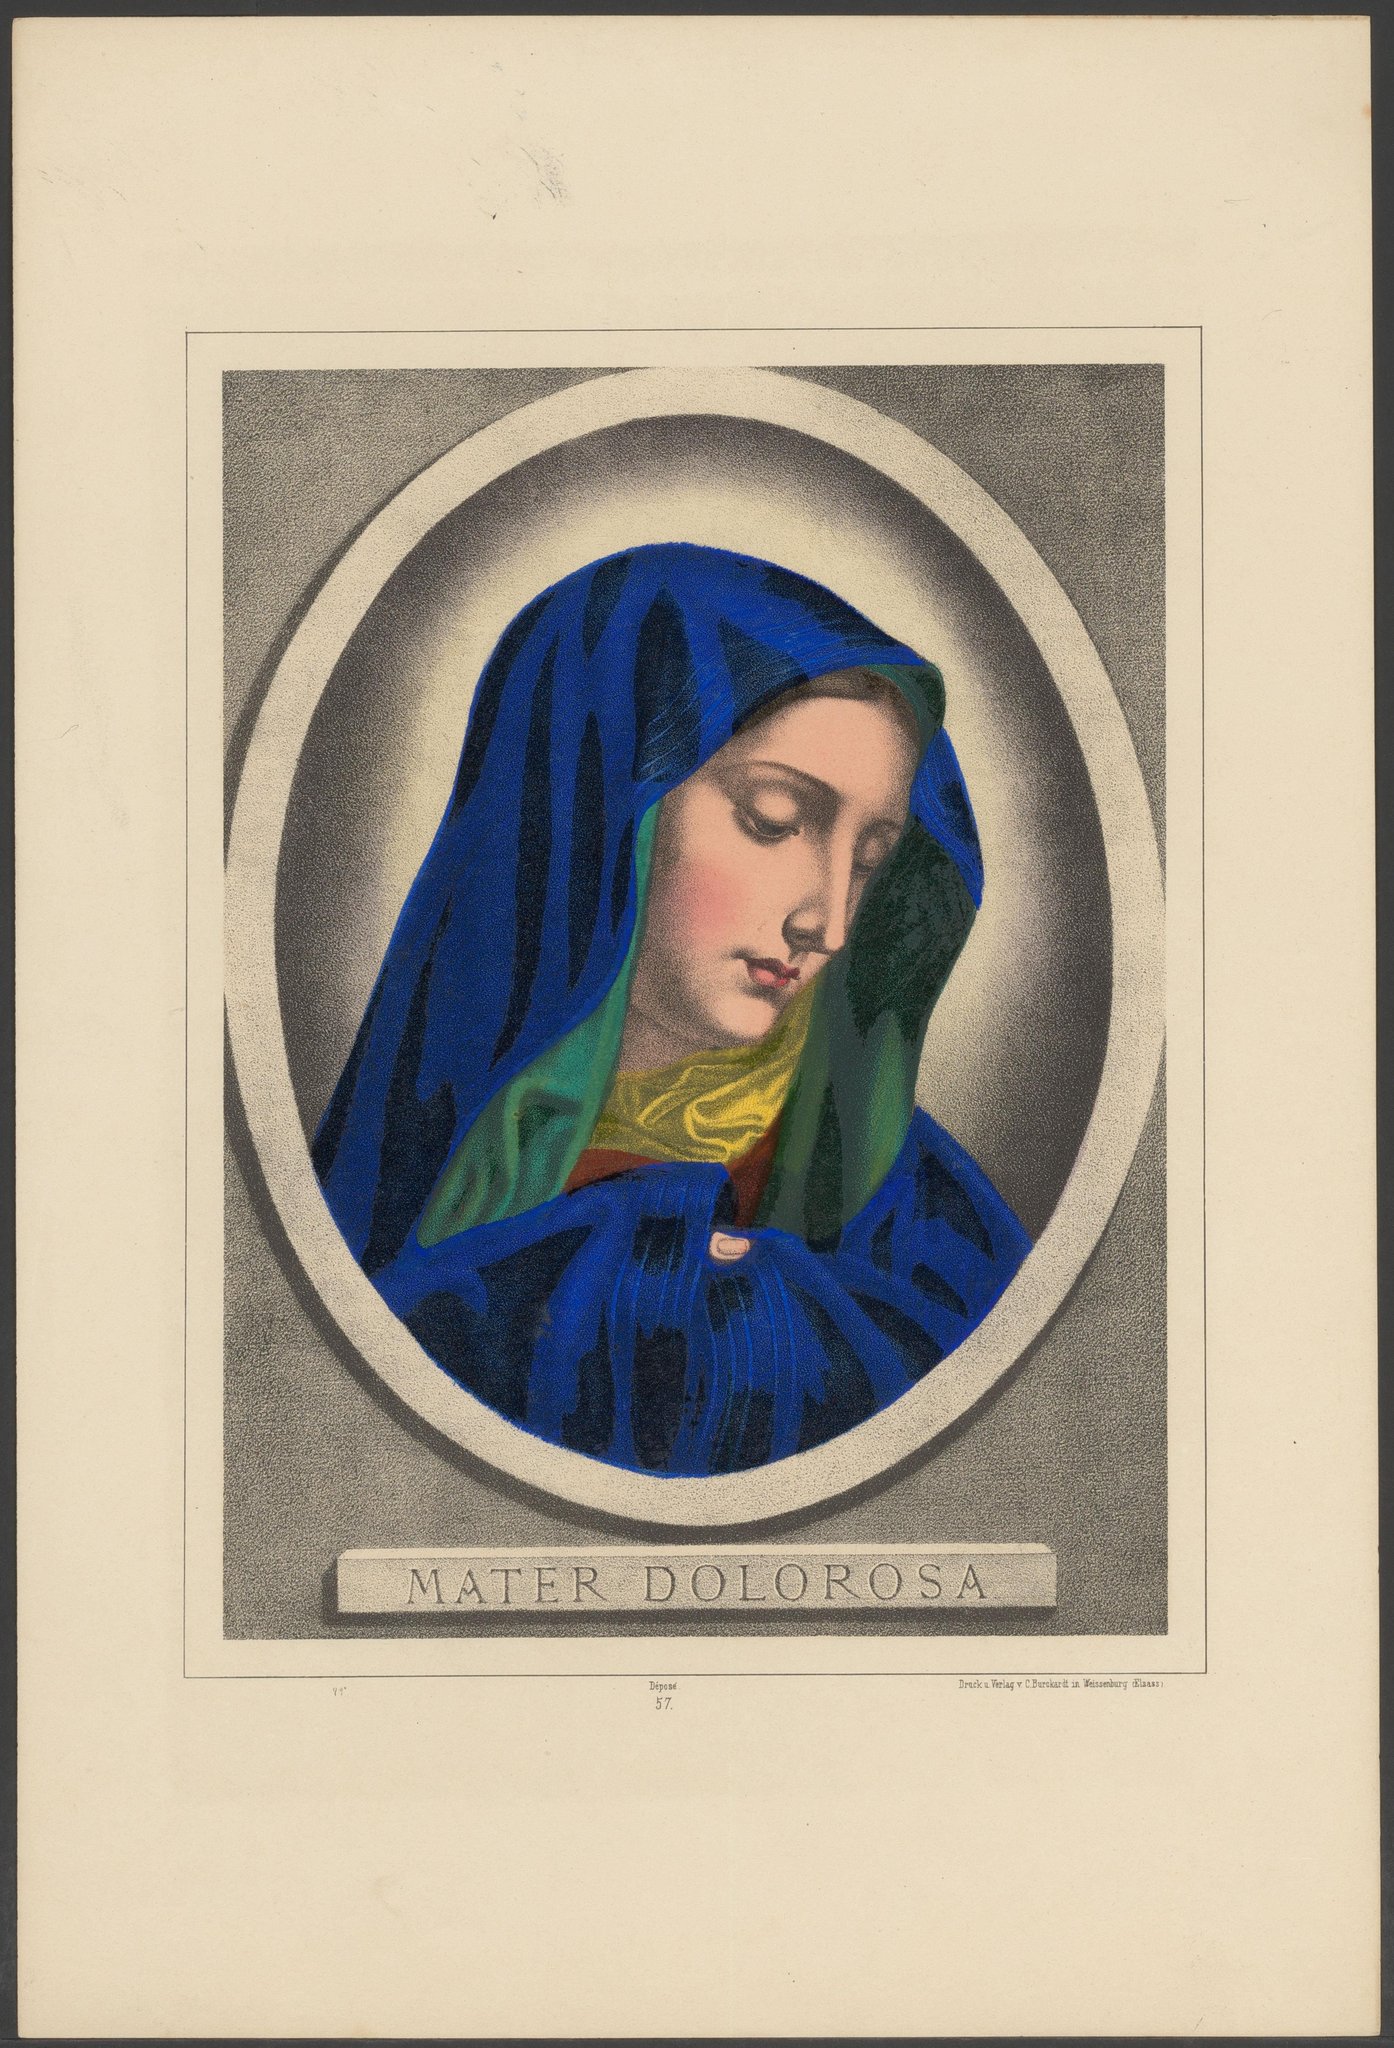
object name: print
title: Mater Dolorosa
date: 1870-1906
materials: lacquer, paper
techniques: brush, chromolithography, hand coloring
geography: wissembourg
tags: 'mater dolorosa'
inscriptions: collector's mark: Lugt 1641, stamp, : ‘Déposé’, stamp: Lugt 2233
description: Onderaan genummerd: 57. Onderwerpsrubrieken binnen de Atlas Zeden en Gewoonten: Godsdienst, Figuren van Christus en heiligen.